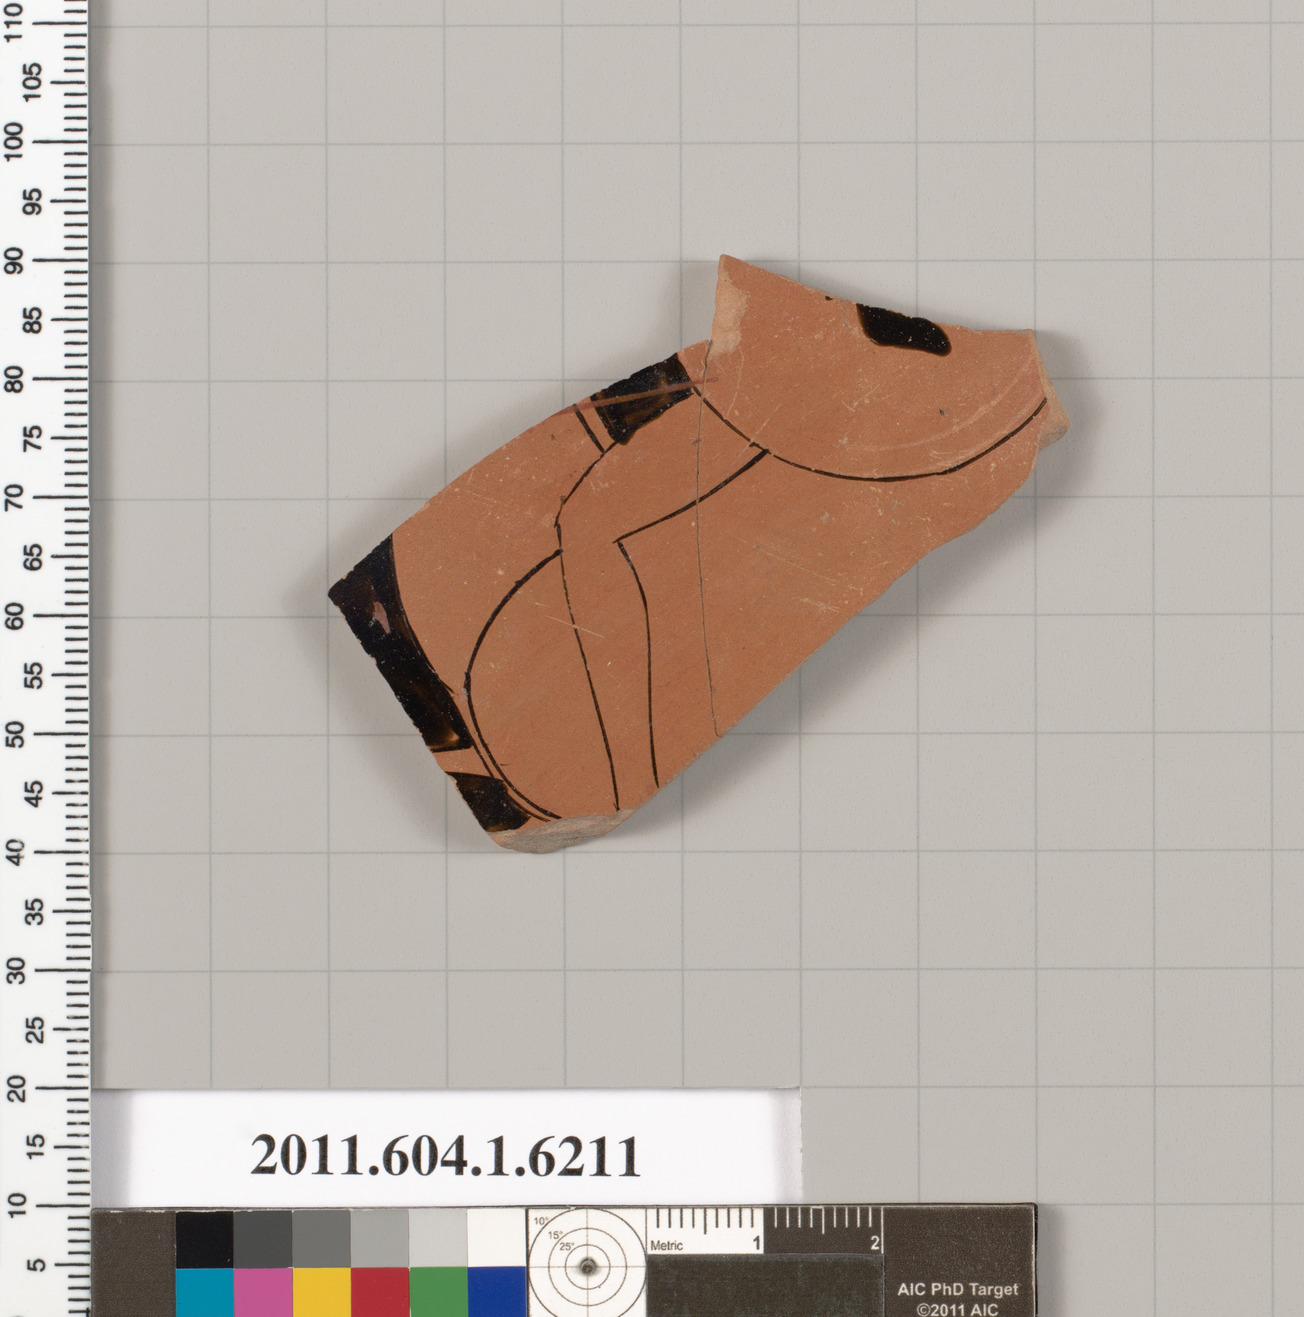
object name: kylix fragment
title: Terracotta fragment of a kylix (drinking cup)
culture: greek, attic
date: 510-500 BCE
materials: terracotta